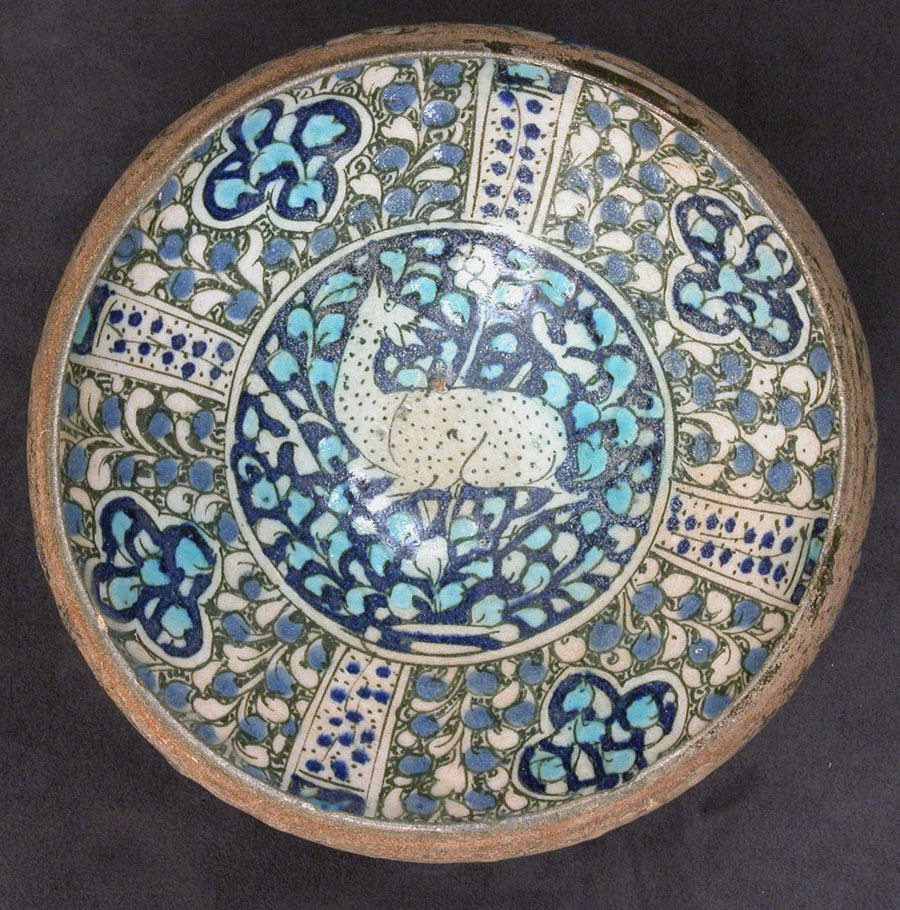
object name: bowl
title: Bowl with Deer Motif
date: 1301-1400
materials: stonepaste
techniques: painting, underglaze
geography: iran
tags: deer